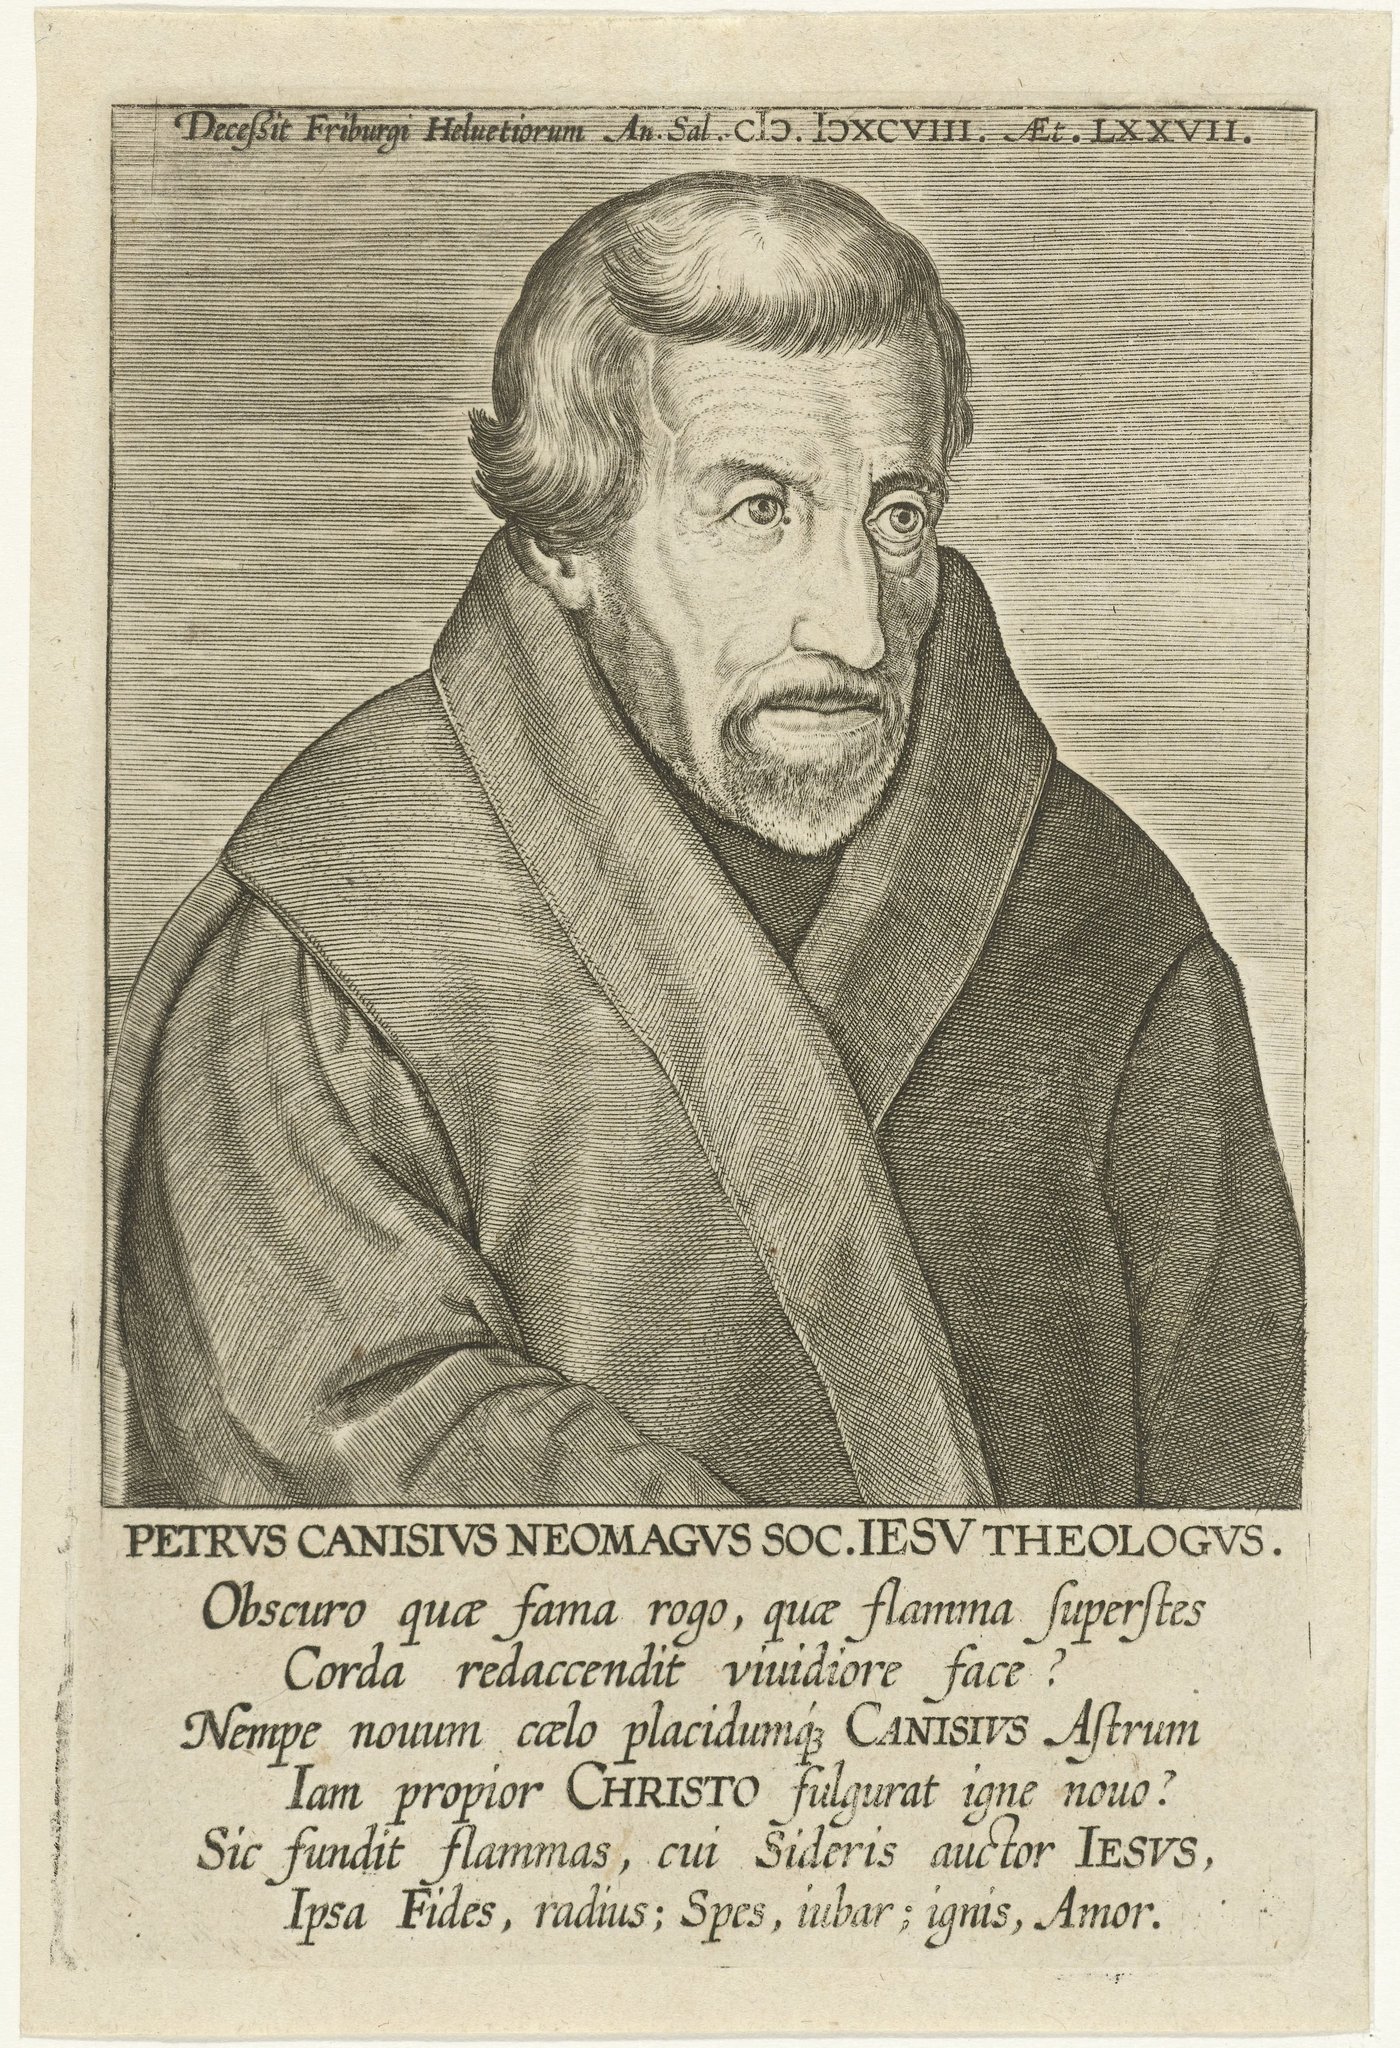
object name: book illustration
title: Portret van Petrus Canisius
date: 1604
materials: paper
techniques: engraving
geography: antwerp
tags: nijmegen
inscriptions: collector's mark: Lugt 2228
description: Portret van Petrus Canisius, theoloog en Jezuïet. De prent heeft een Latijns boven- en onderschrift en maakt deel uit van een serie van bekende schrijvers uit de Nederlanden.